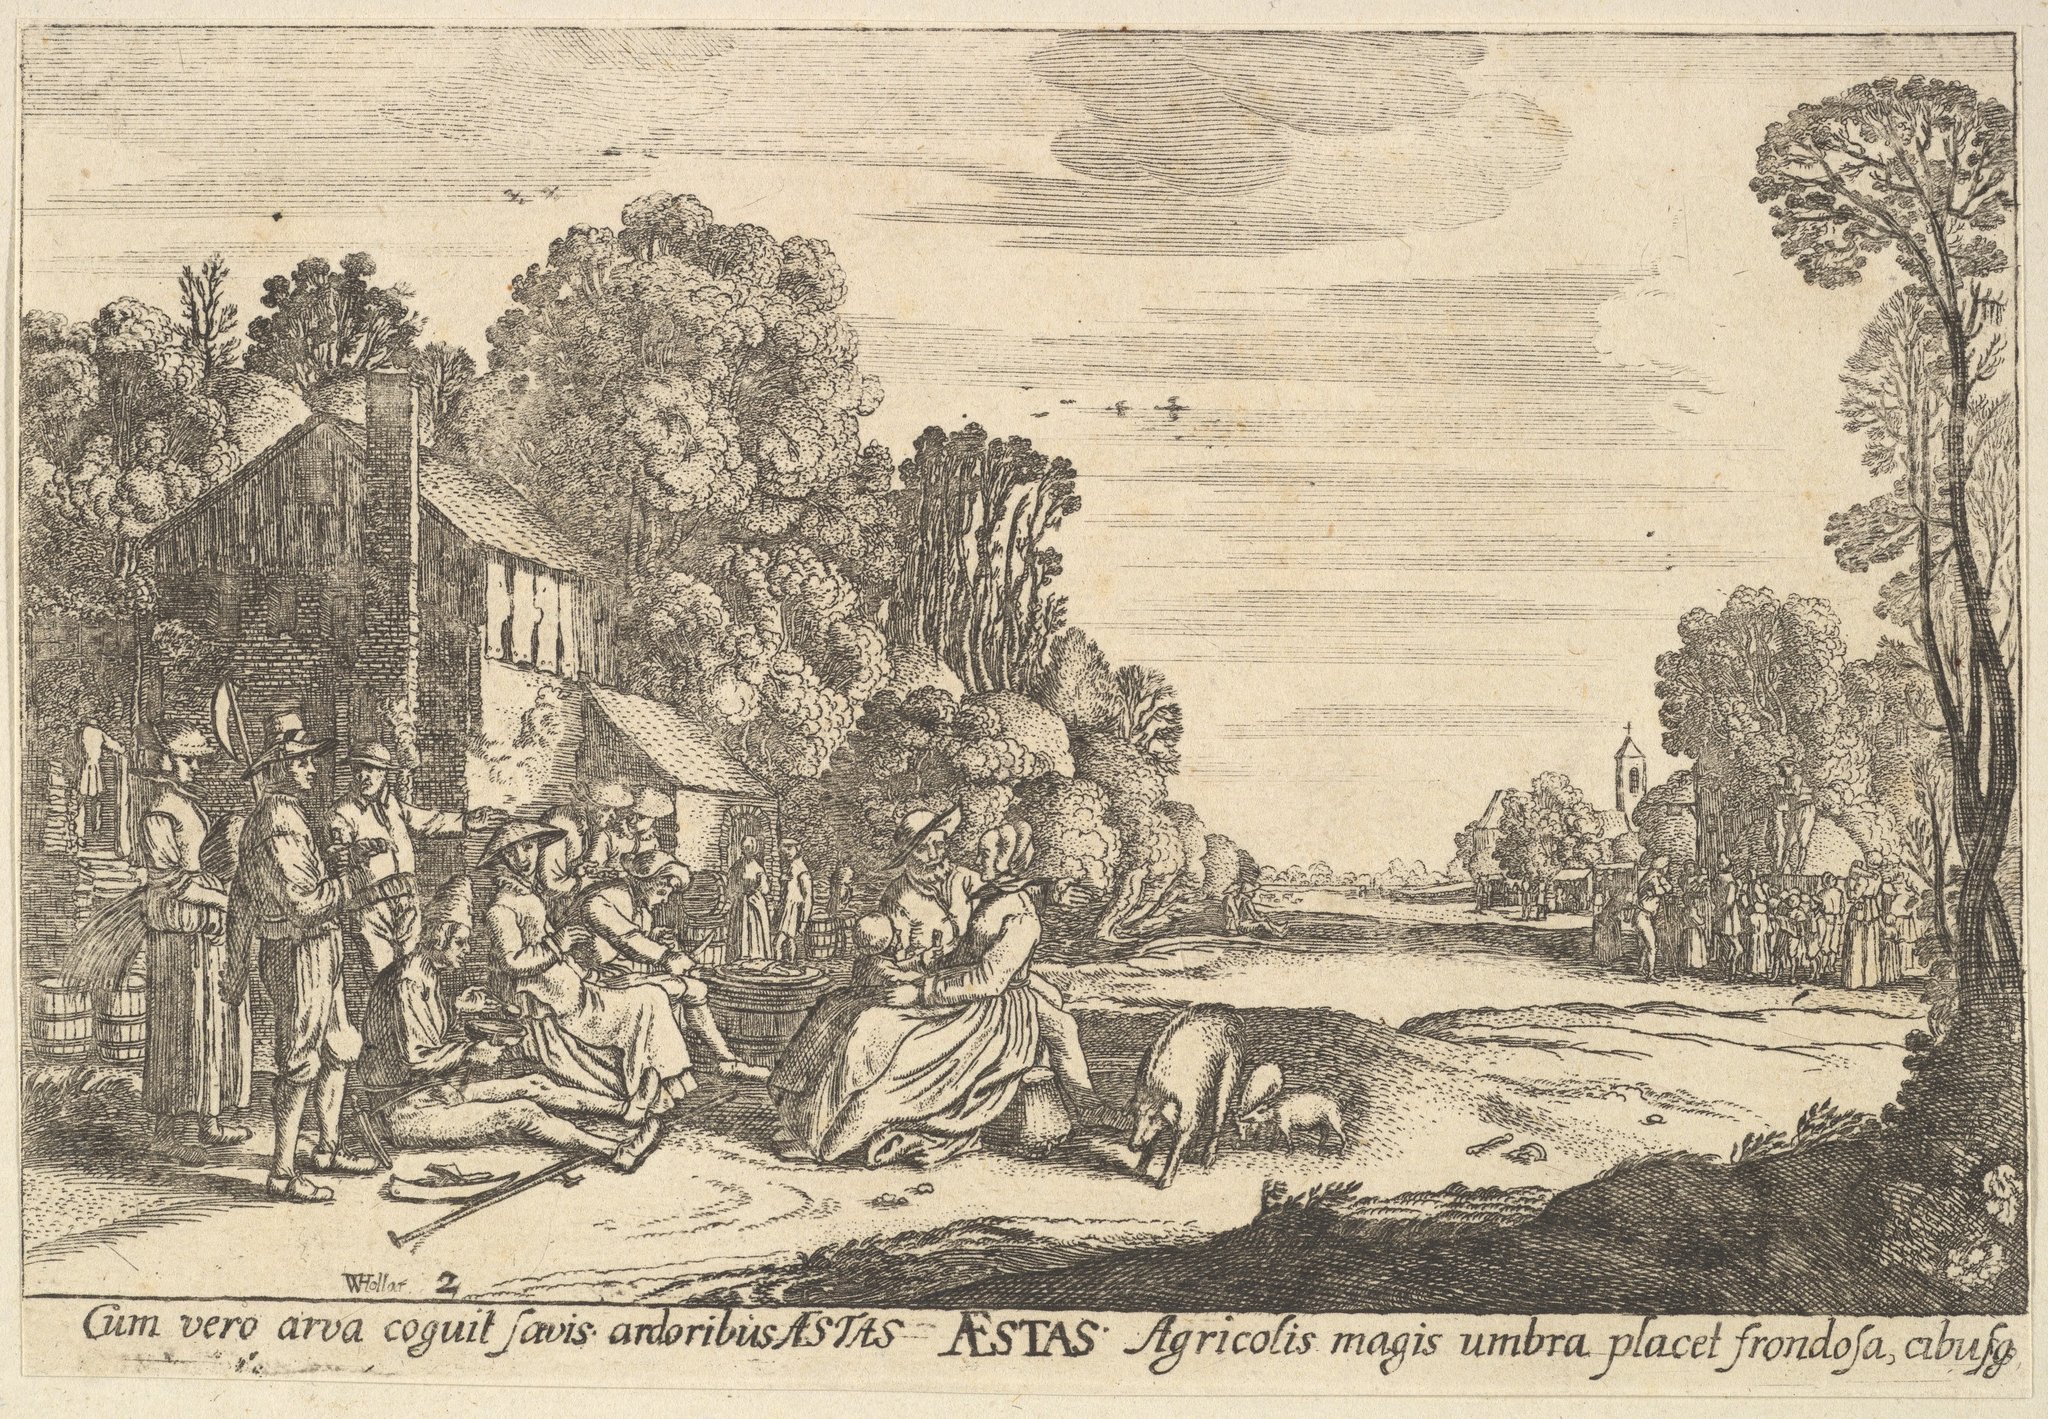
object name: print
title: Summer (Aestas)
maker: wenceslaus hollar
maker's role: artist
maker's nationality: bohemian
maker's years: 1607-1677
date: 1629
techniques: etching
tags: houses,men,women,trees,summer